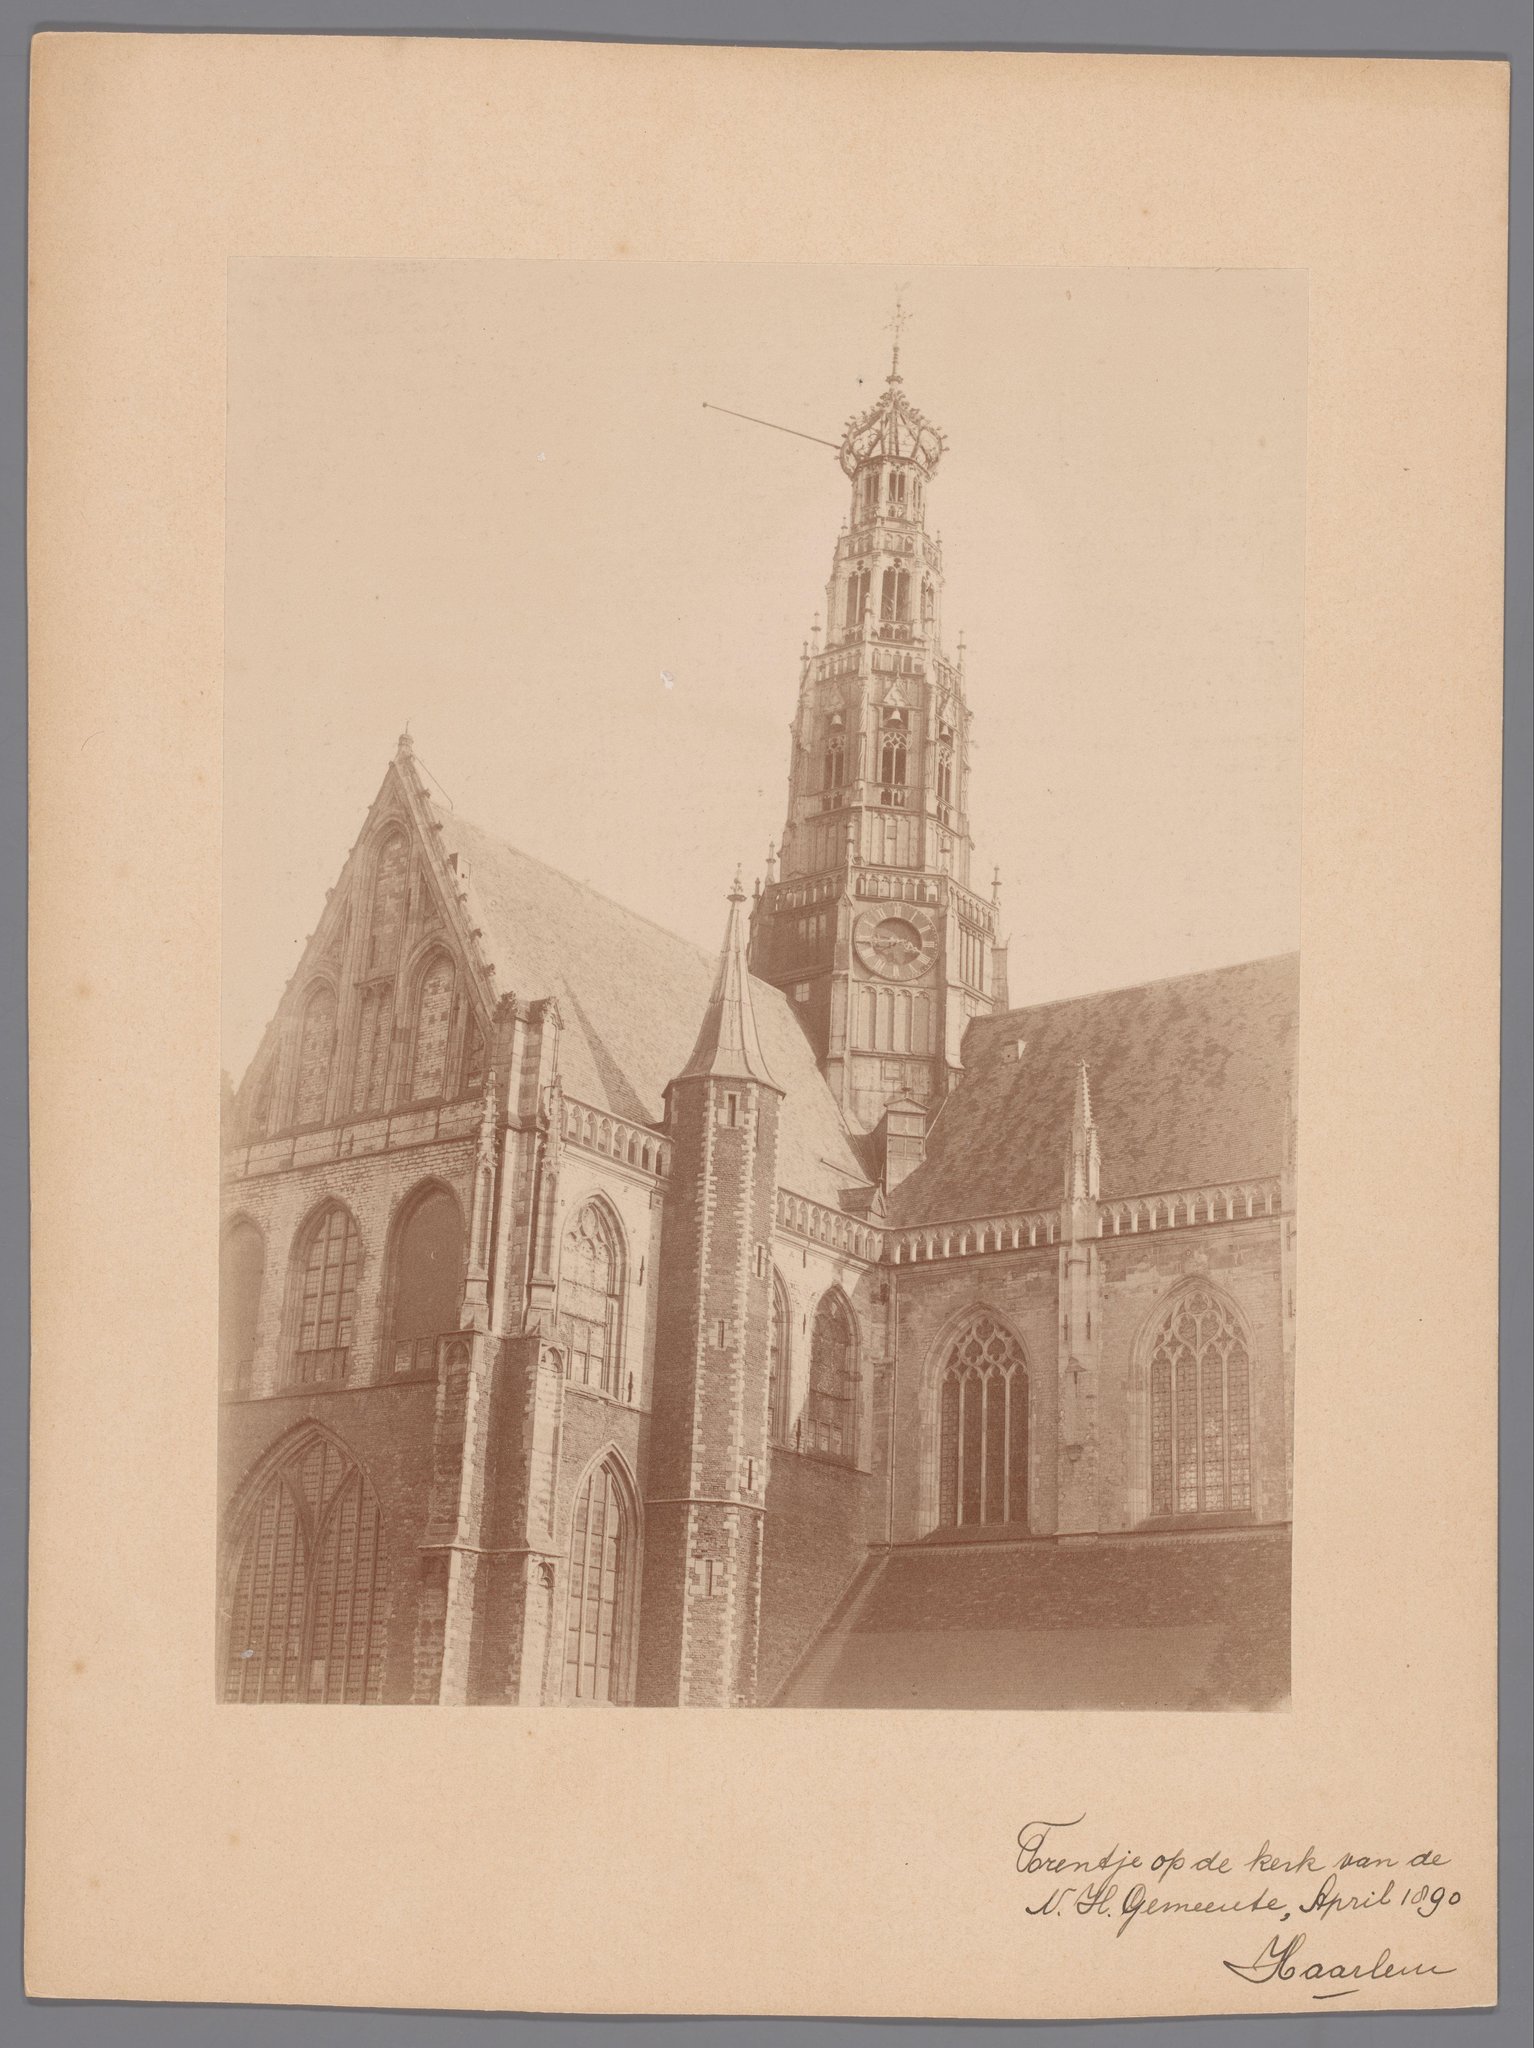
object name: photograph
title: Toren van de Grote of Sint-Bavokerk te Haarlem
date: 1890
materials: cardboard, photographic support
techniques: albumen print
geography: haarlem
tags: church (exterior), tower (of house or building)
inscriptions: annotation: ‘Torentje op de kerk van de N.H. Gemeente, April 1890/ Haarlem’, annotation: ‘Torentje op de Kerk v/d N.H. gemeente te Haarlem/ April 1890’